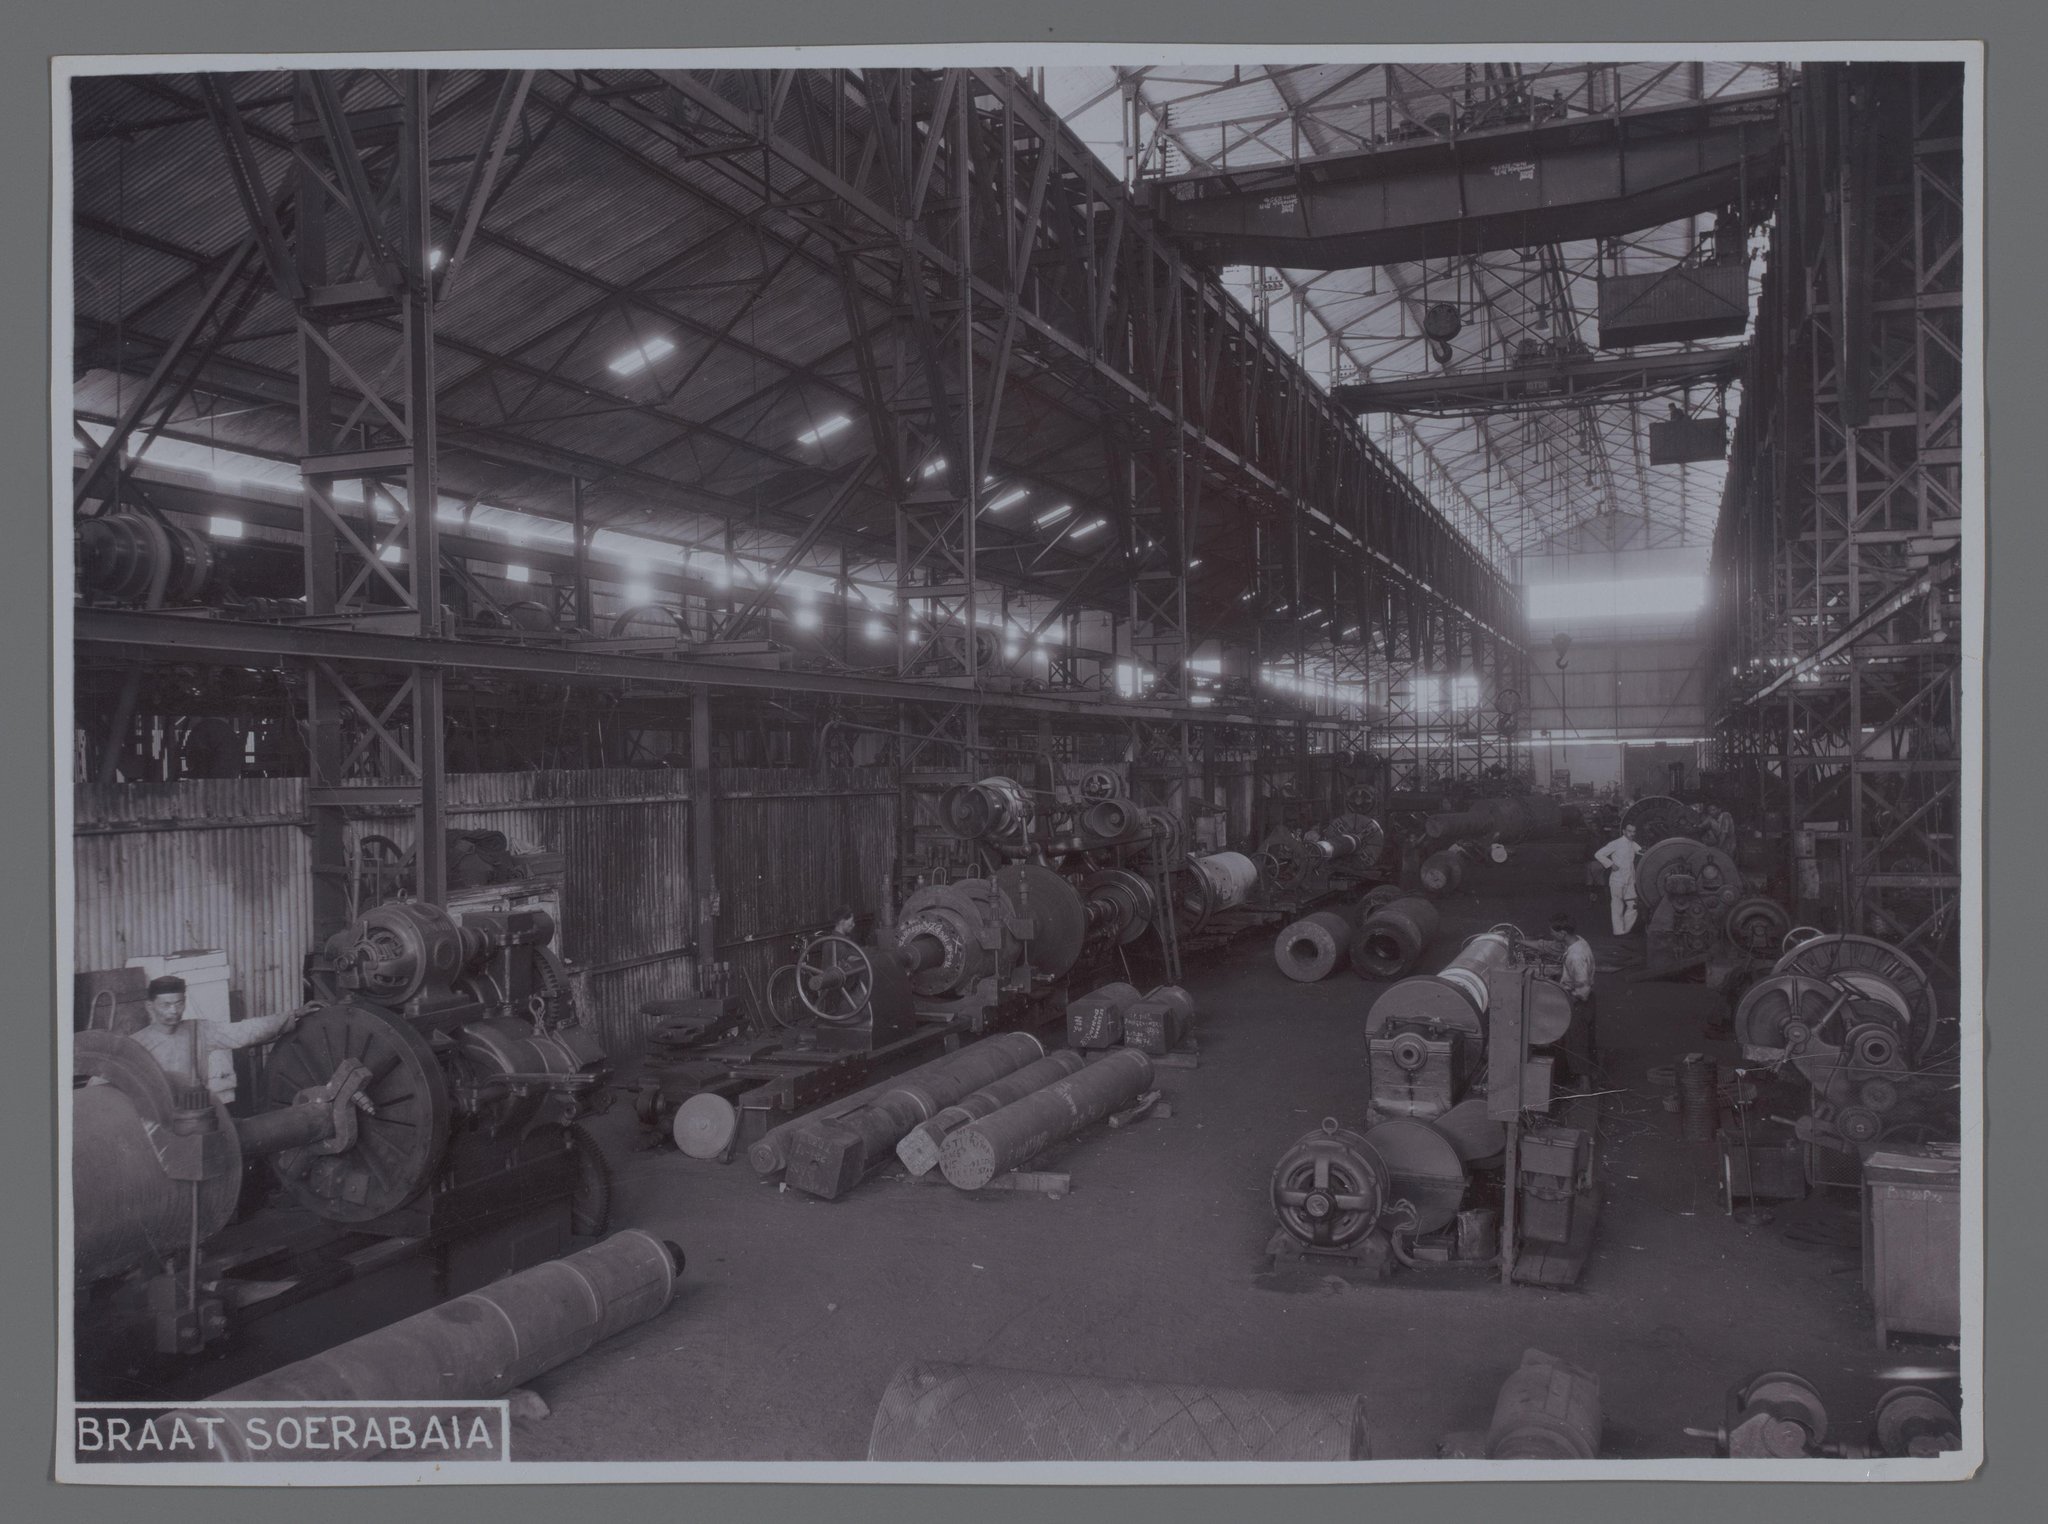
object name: photograph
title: Molen draaierij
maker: Anonymous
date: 1925-1935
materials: photographic support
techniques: photography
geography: surabaya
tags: colonial system, factory-interior, machine shop, machines; parts of machines; tools and appliances, java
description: Fabriekshal met de molendraaierij te Soerabaja, ca. 1930. Onderdeel van de multomap met foto's van machines van de N.V. Machinefabriek Braat te Soerabaja, Soekaboemi en Jogyakarta, uit de periode 1908-1942.